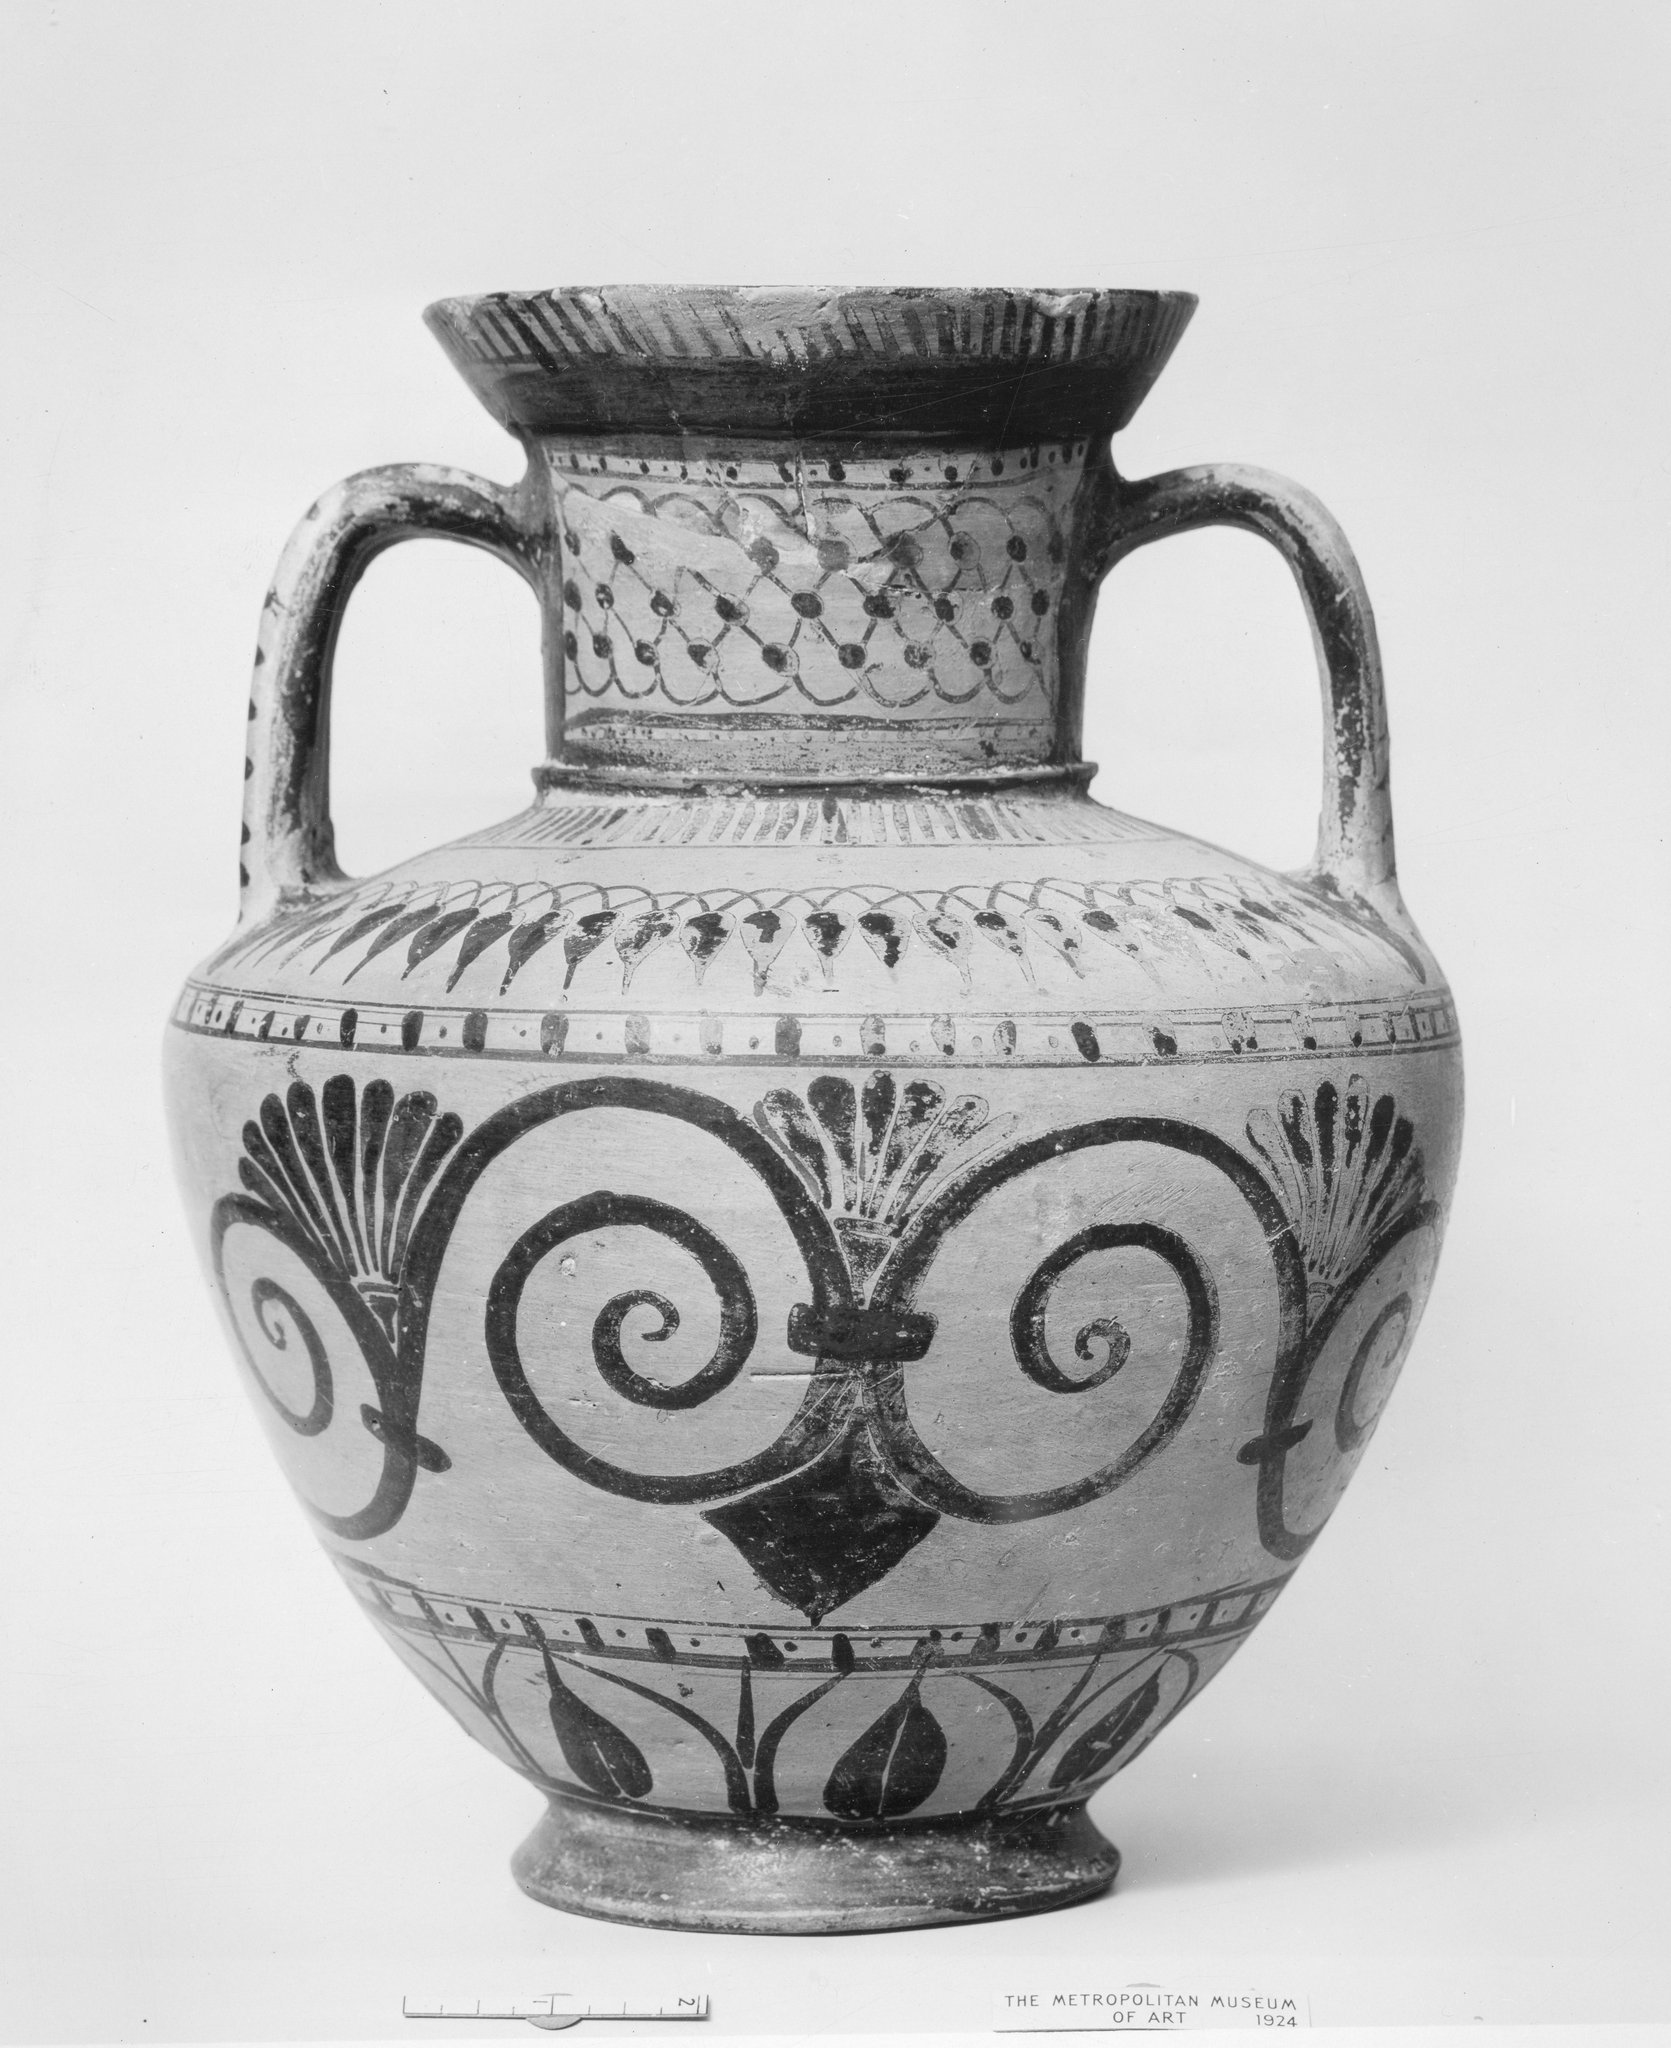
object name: amphora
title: Terracotta amphora (storage jar)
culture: rhodian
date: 530 BCE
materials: terracotta